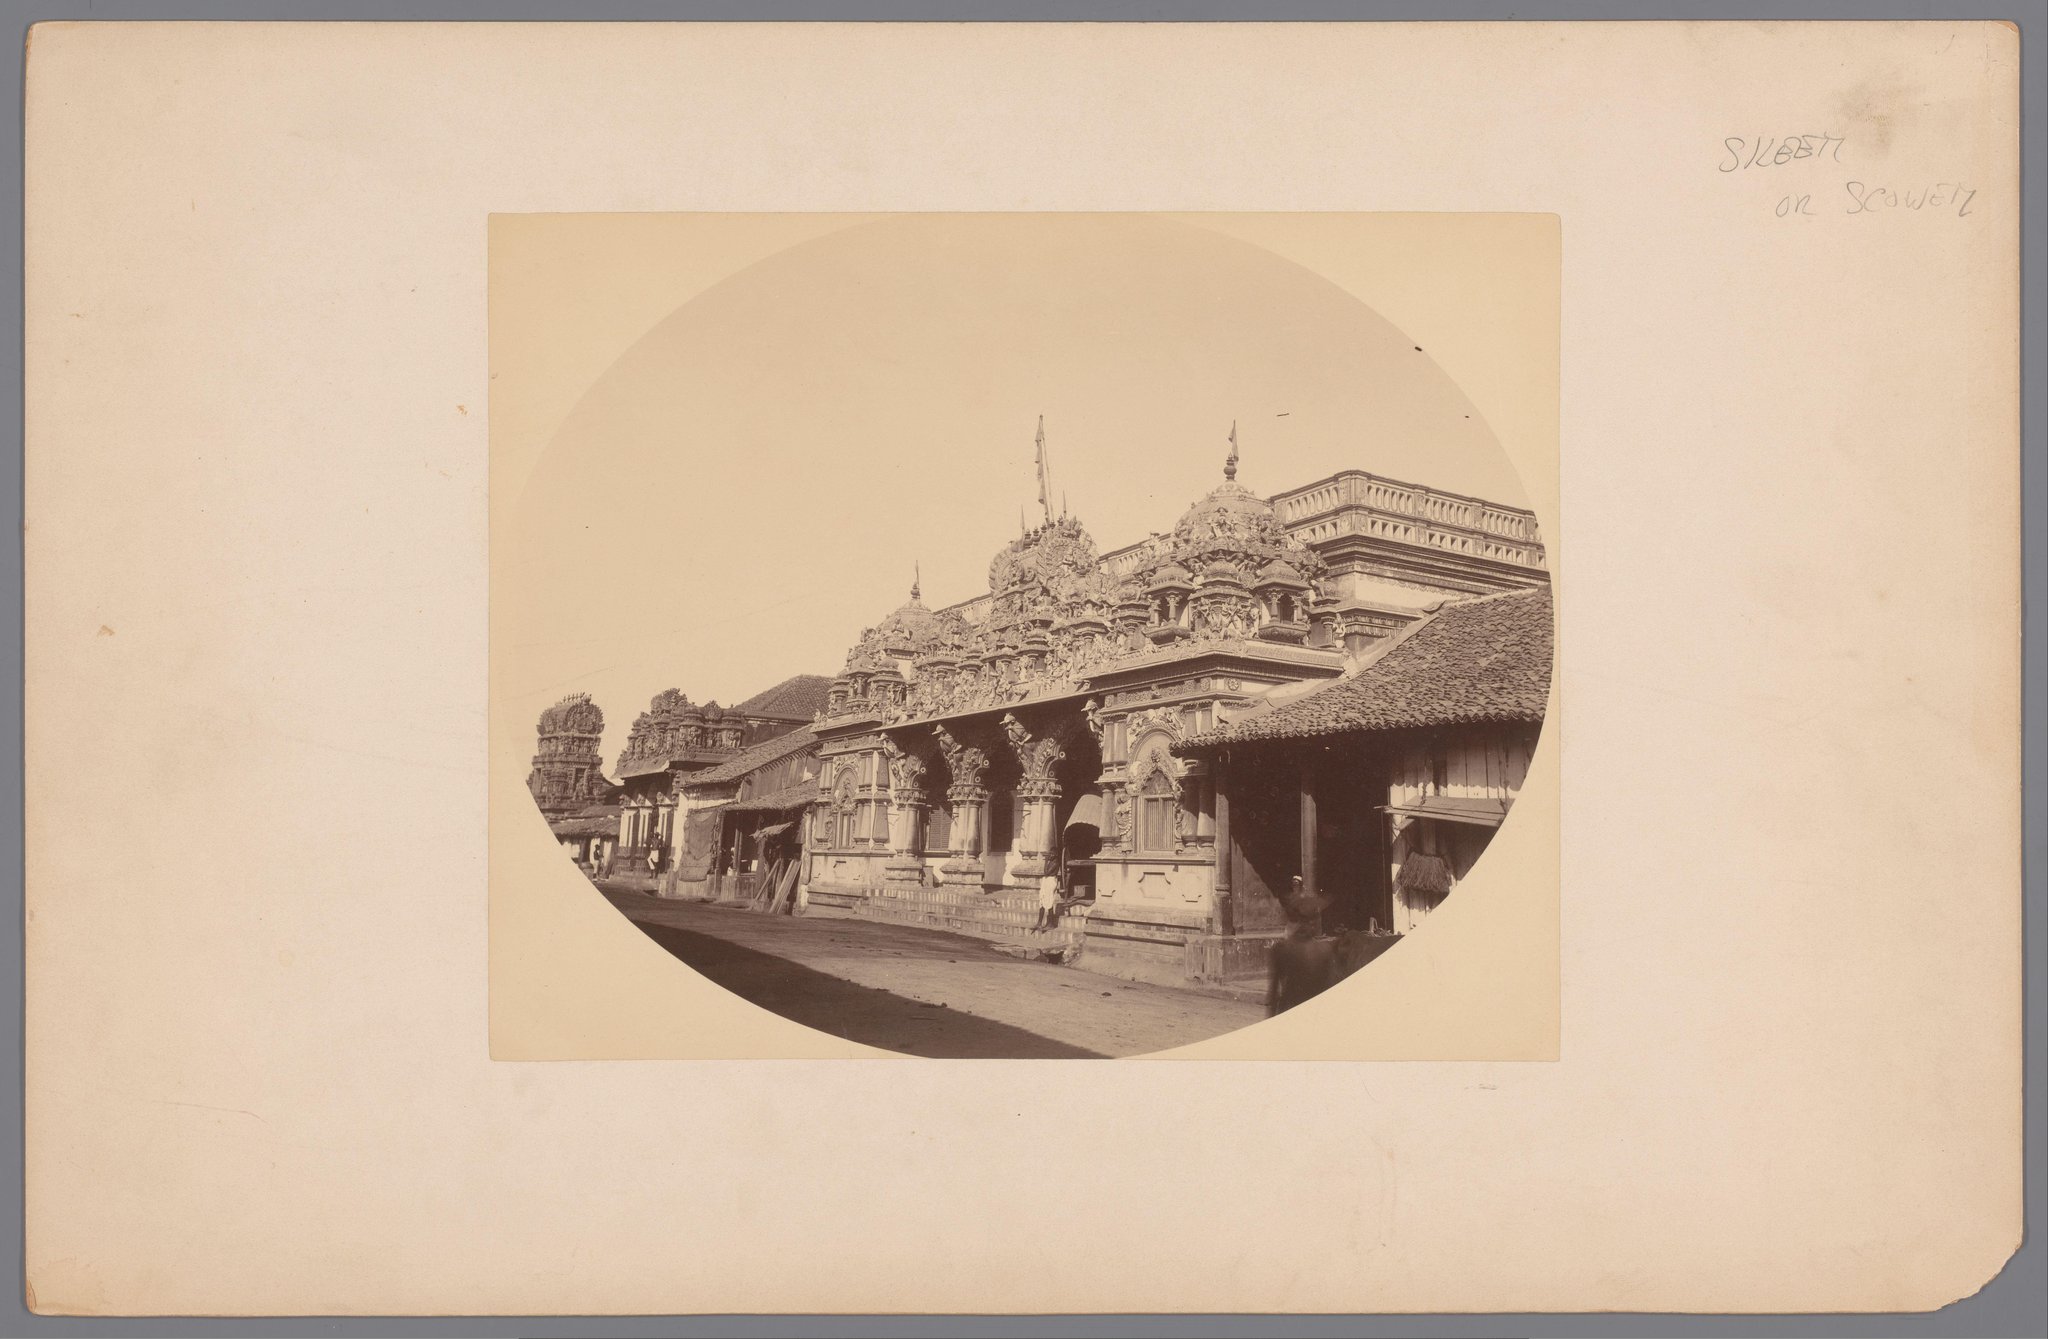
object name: photograph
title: Hindu temple on the Sea Street, Colombo, Sri Lanka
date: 1880-1895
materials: cardboard, paper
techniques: albumen print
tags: sri lanka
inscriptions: number: ‘1450’, inscription: ‘f 75,-’, inscription: ‘SKEEN/ OR SCOWEN’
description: Gezicht op tempel van schuin voor (rechts), met enkele mannen.